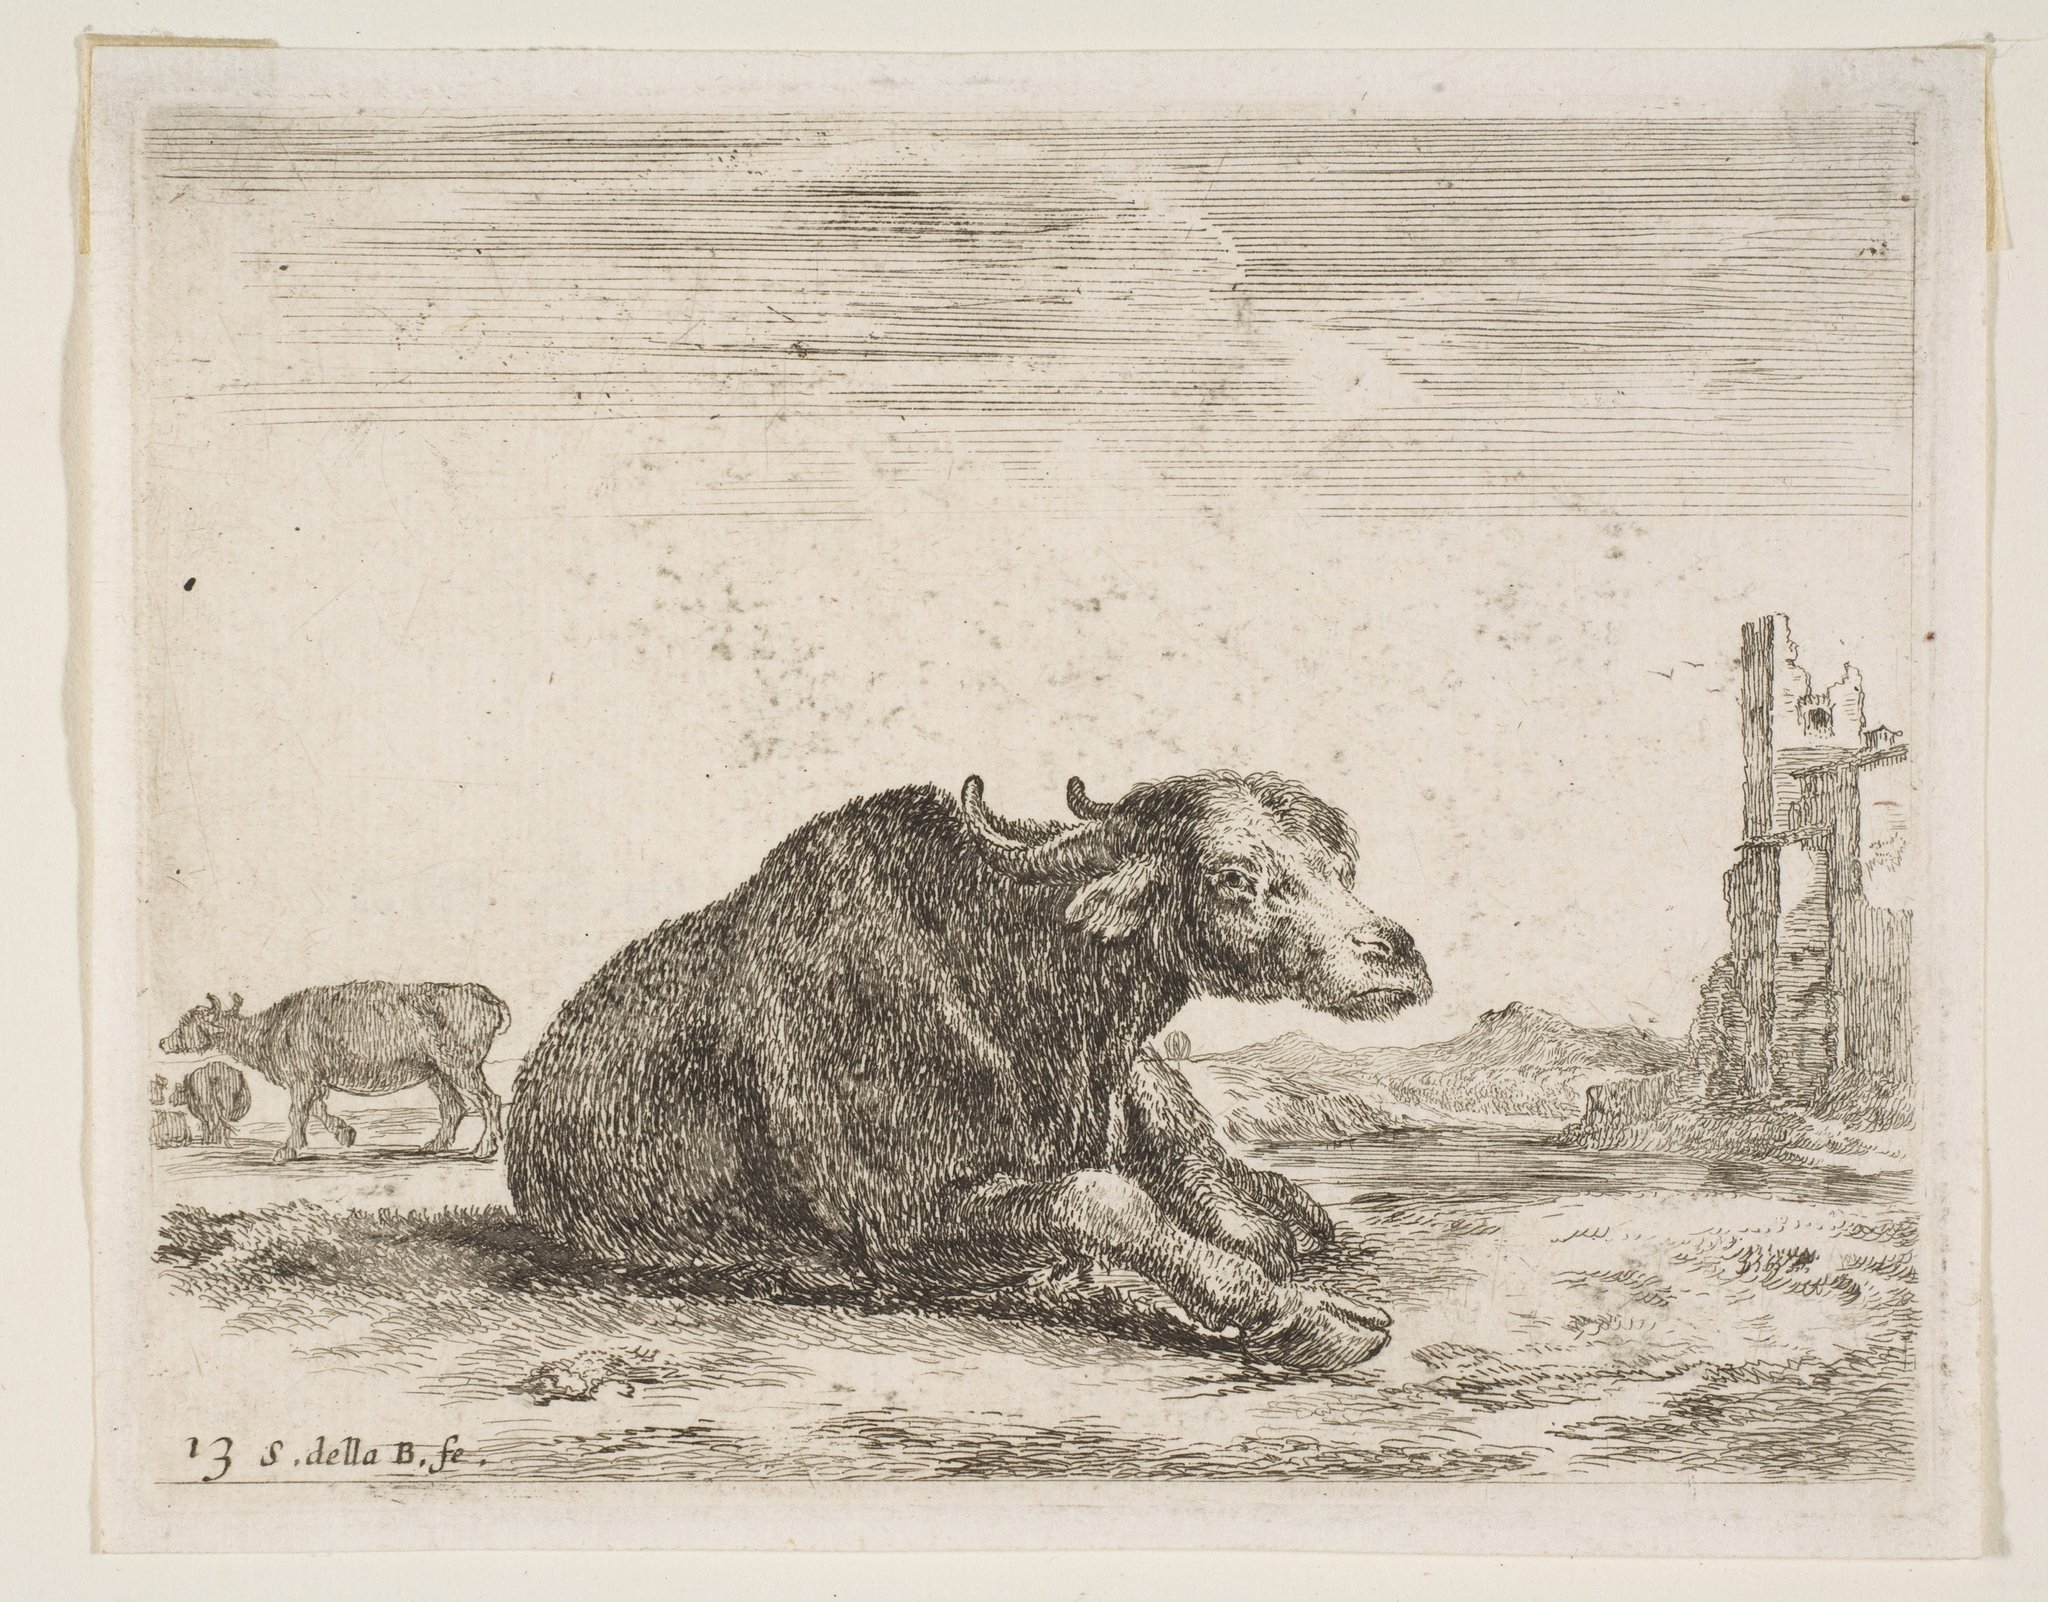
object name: print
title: Buffalo lying down, plate 13 from "Various Animals" (Diversi Animali)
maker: stefano della bella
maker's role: artist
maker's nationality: italian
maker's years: 1610-1664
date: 1641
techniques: etching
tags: buffalos